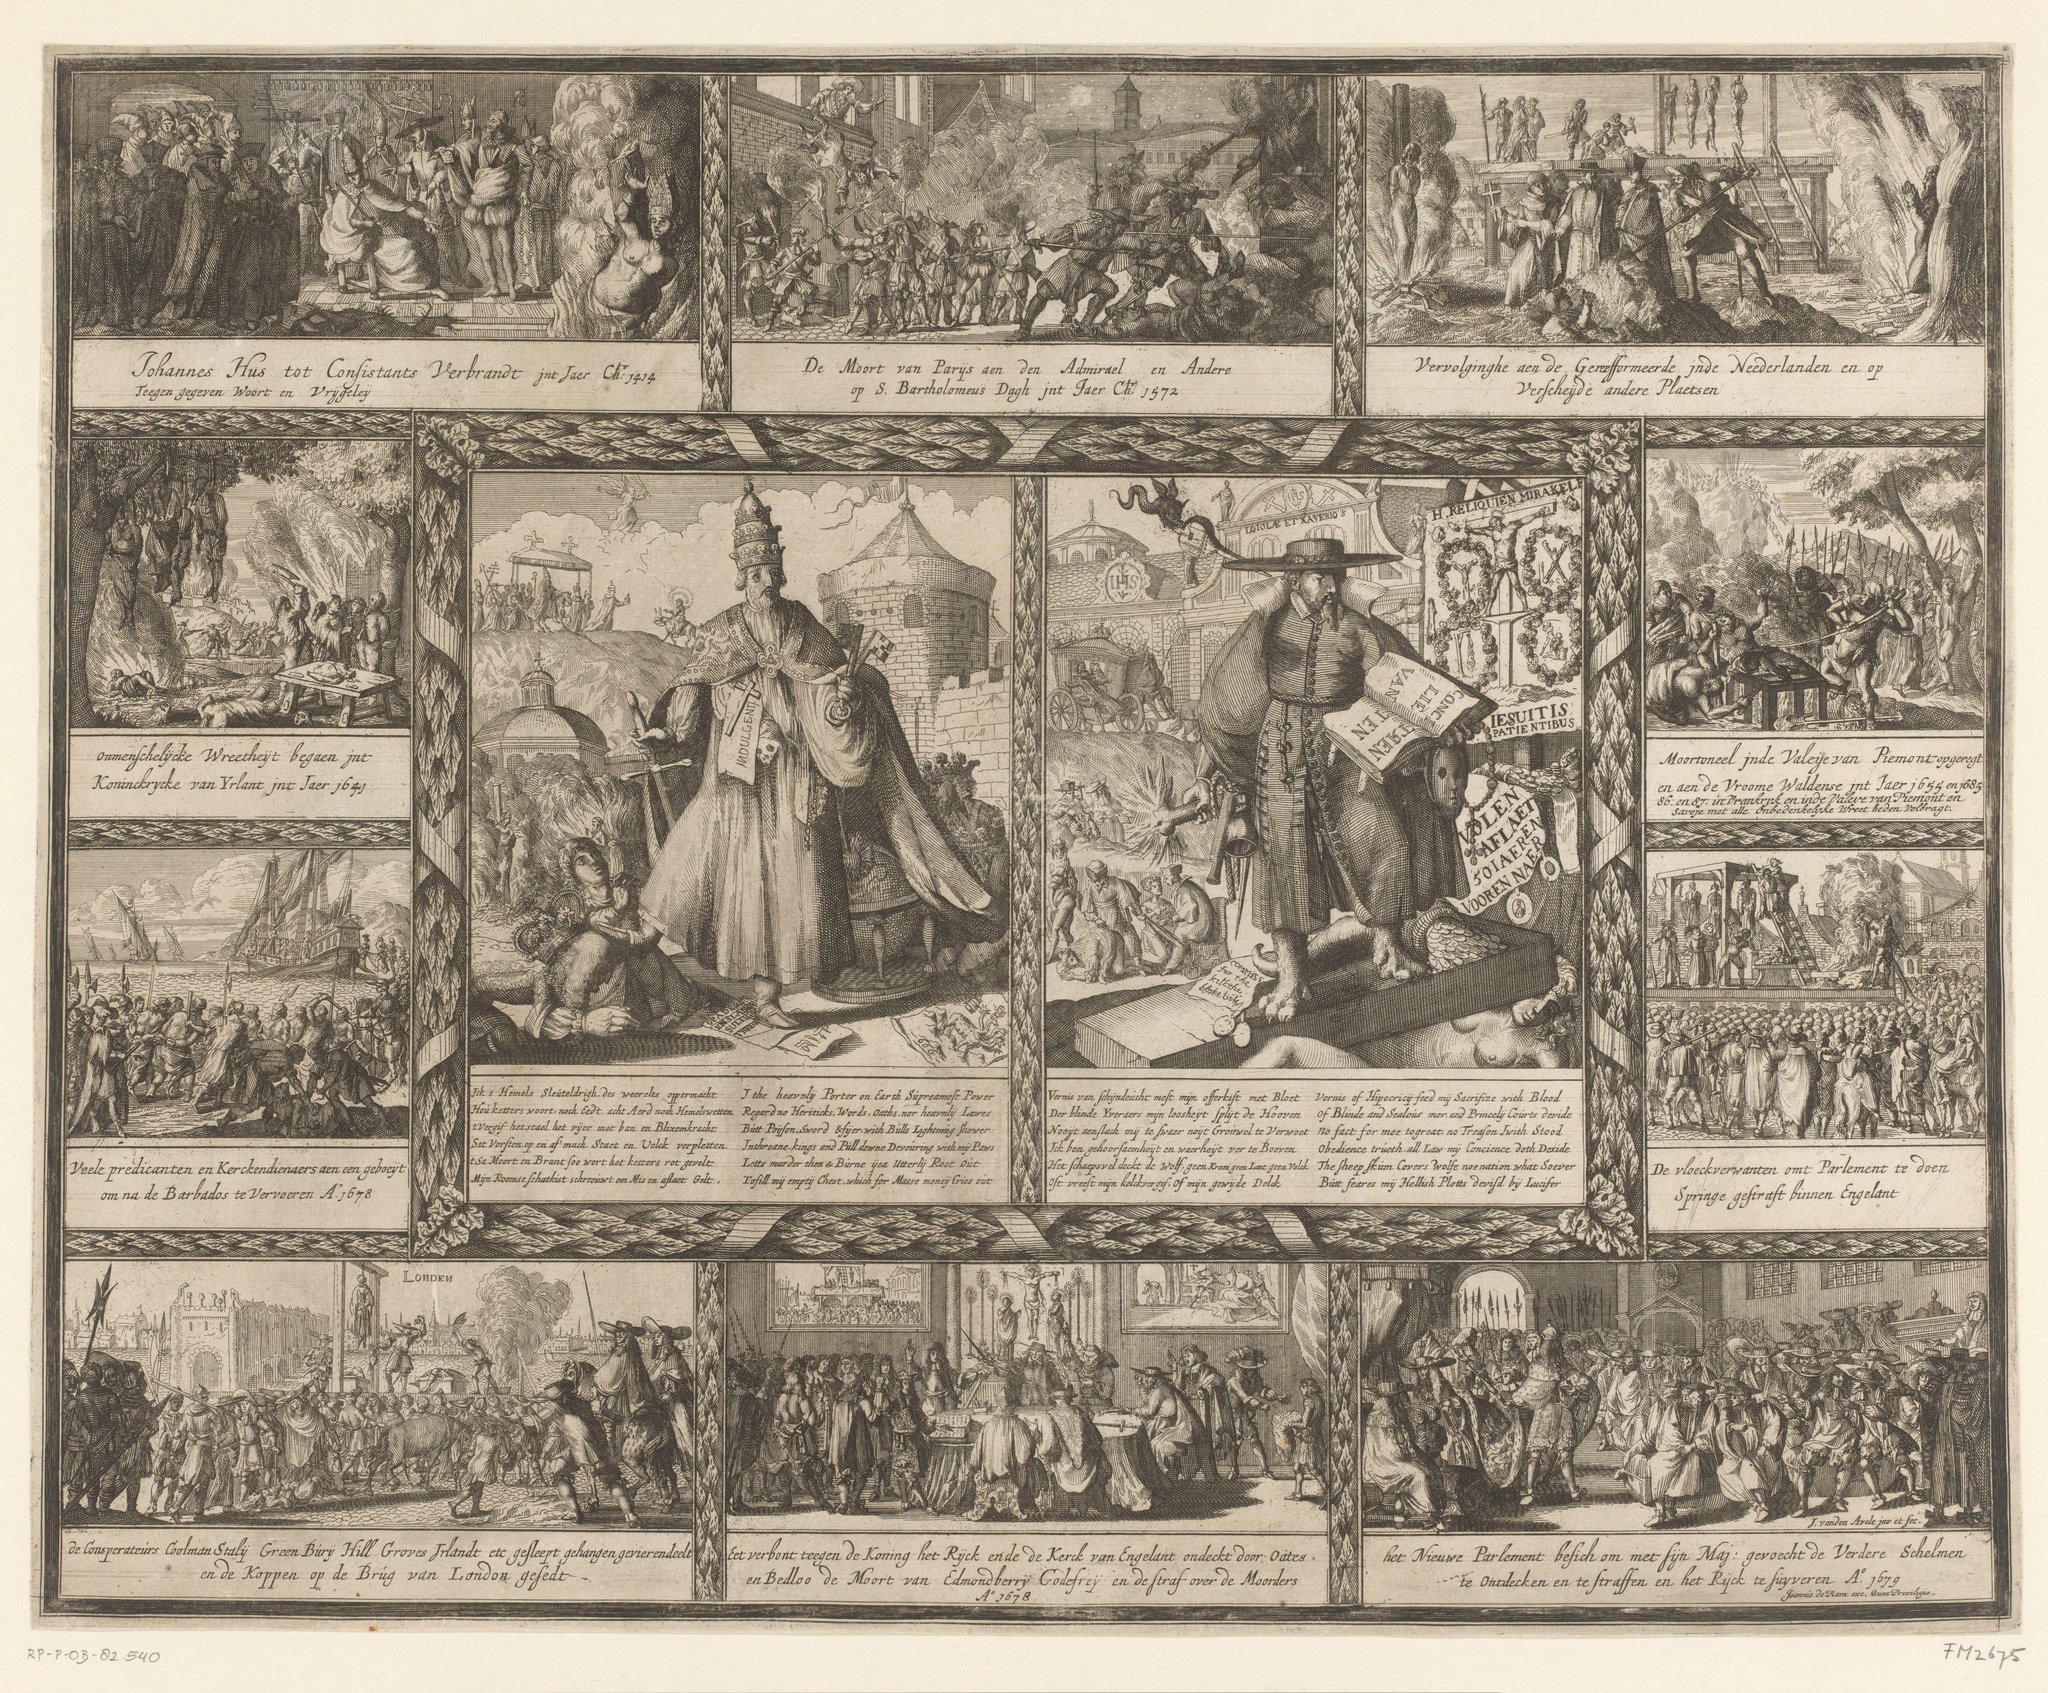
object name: propagandaprent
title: Vervolging van de protestanten in Engeland, 1685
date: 1685-1687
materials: paper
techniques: engraving, etching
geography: northern netherlands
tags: execution of heretic, e.g. by burning at the stake, 'auto-da-fé', violent death, being killed; being mishandled and maltreated; seeking death, england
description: Vervolging van de protestanten in Engeland, Frankrijk, de Nederlanden en Ierland, 1685. Centrale voorstelling omringd door tien kleine scènes die de vervolging van en de wreedheden jegens de protestanten door de katholieken vanaf de verbranding van Jan Hus in 1415 tot aan 1687. Onderaan drie scènes over de gebeurtenissen in Engeland in afgelopen jaren. Centraal twee voorstellingen van de paus die een koning onder de voet houdt en een jezuïet met wolfspoten die de aflaten verkoopt en de waarheid onderdrukt. Bij alle scènes onderschriften in het Nederlands.